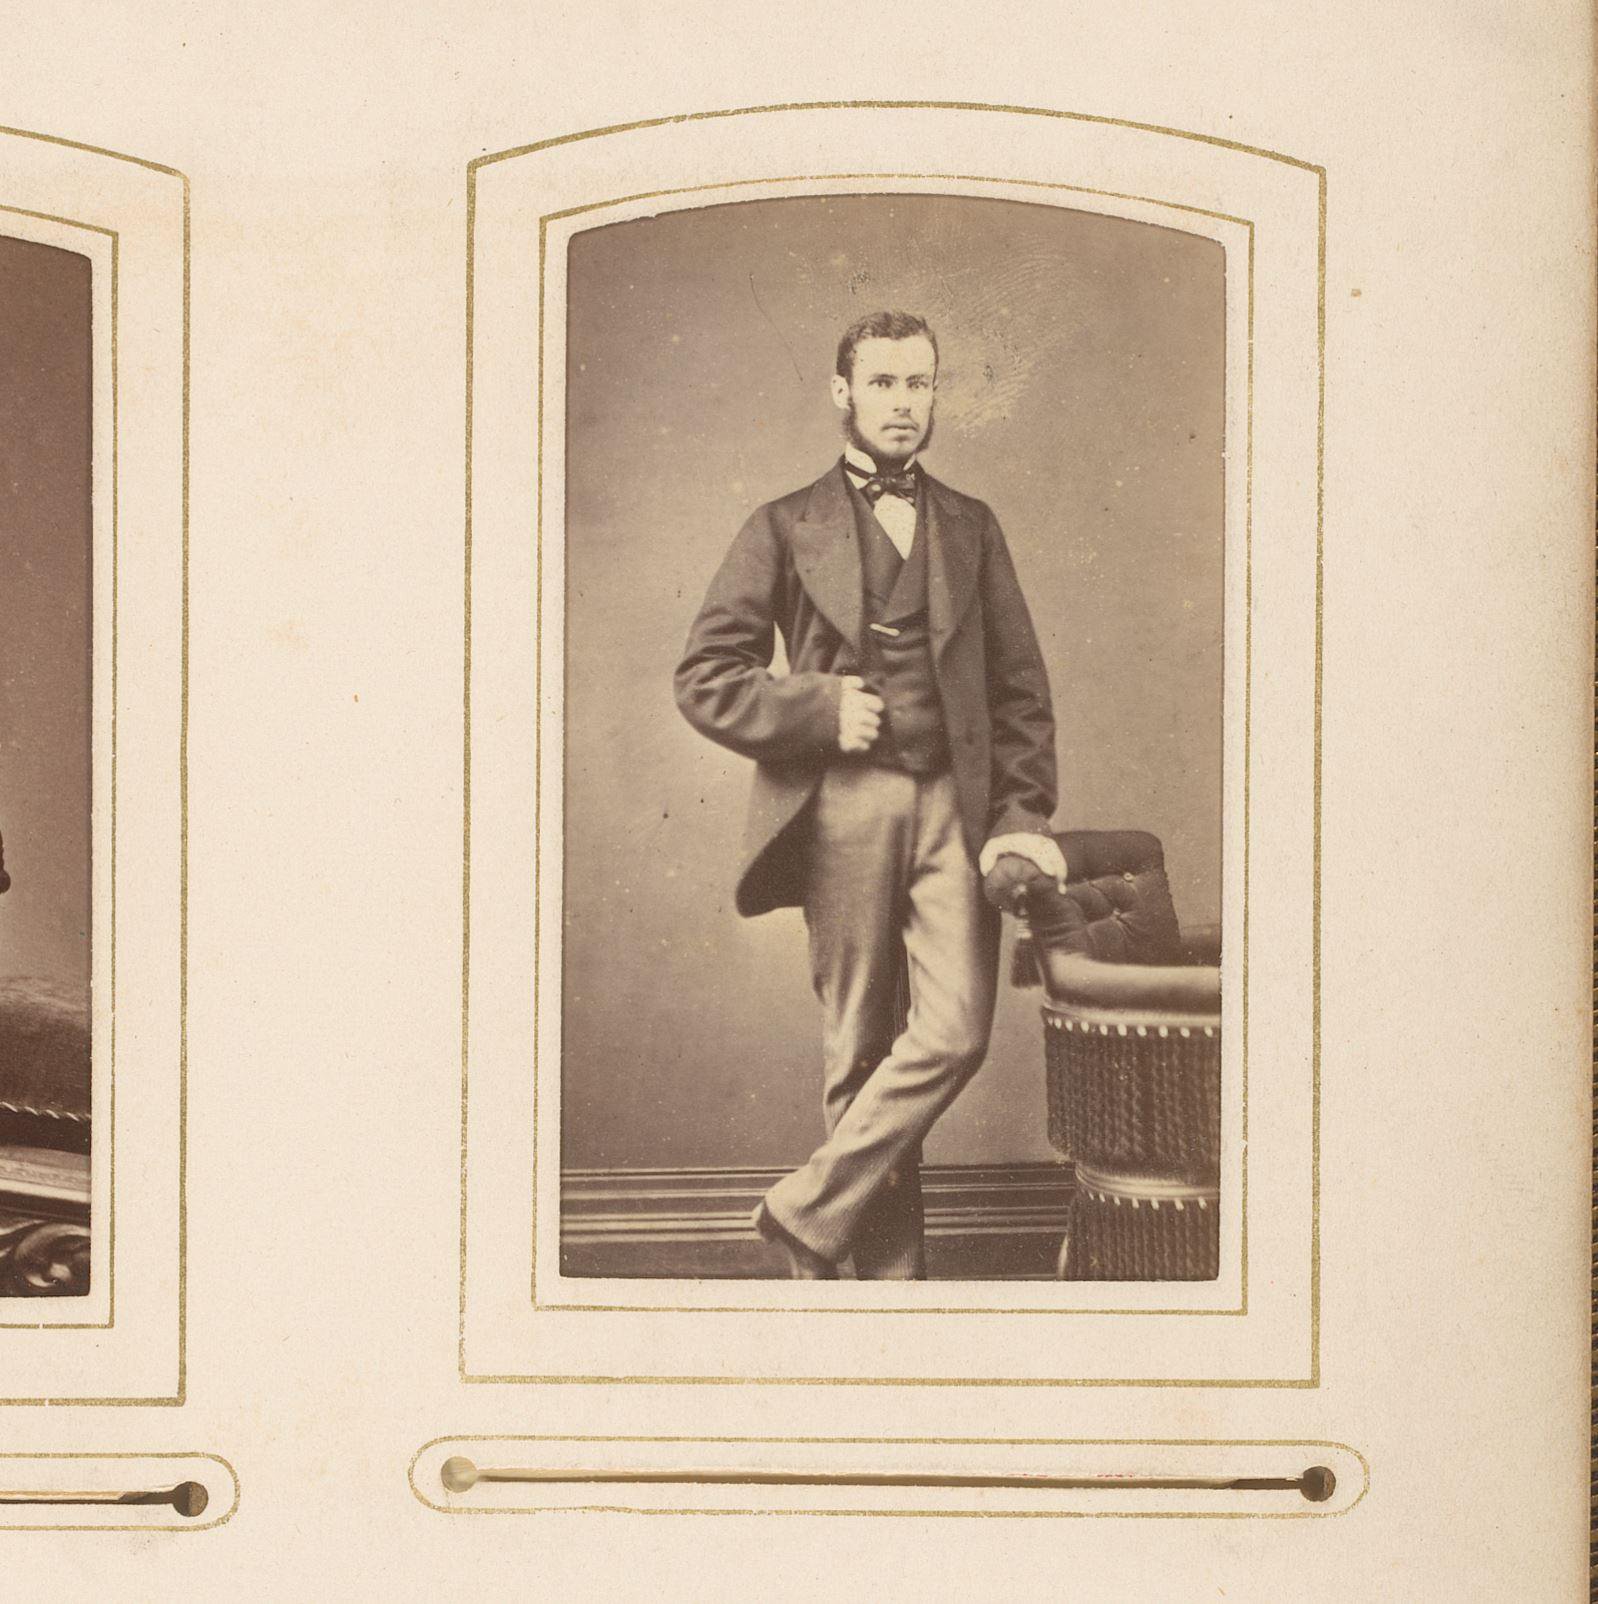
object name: photograph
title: Portret van een man met bakkenbaarden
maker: wardle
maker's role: fotograaf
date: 1860-1900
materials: cardboard, photographic support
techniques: albumen print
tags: sideburns, adult man, historical persons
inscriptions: inscription: ‘Wardle/ Photographer/ 34, Victoria St West/ Grimsby’